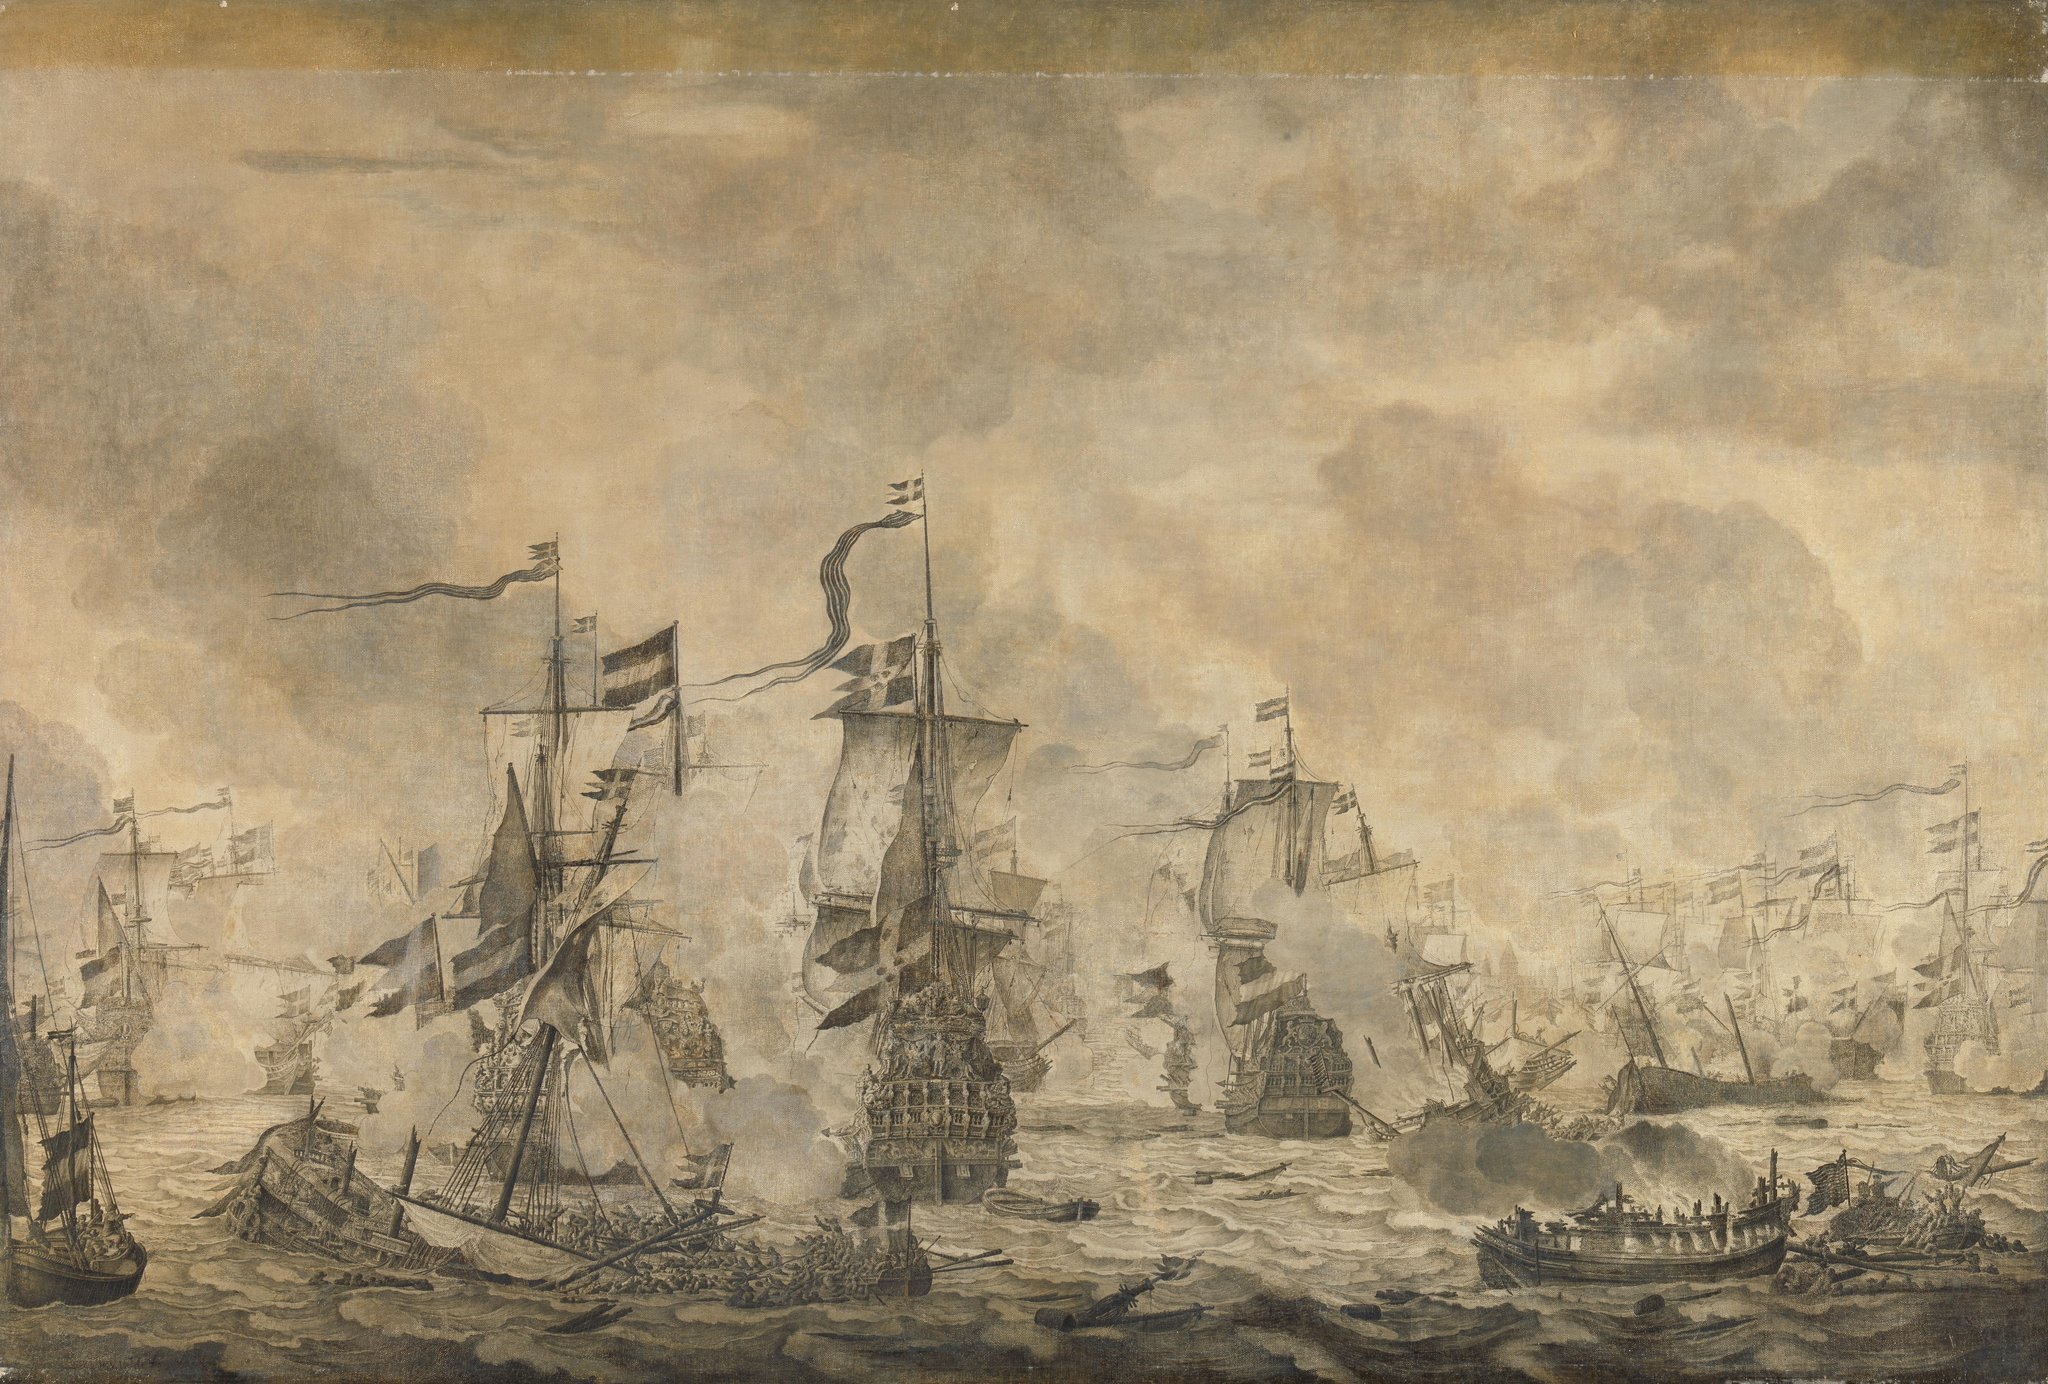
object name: painting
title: Battle between the Dutch and Swedish Fleets, in the Sound, 8 November 1658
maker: willem van de velde (i)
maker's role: draughtsman, painter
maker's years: 1611-1693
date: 1665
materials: canvas, oil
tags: battle (+ sailing-ships)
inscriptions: signature and date: ‘W. v. Velde f. 1665’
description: Episode uit de slag in de Sont tussen de Hollandse en de Zweedse vloot, 8 november 1658. Op de voorgrond een zinkend Zweeds oorlogsschip, een brander en enkele sloepen met overlevenden.